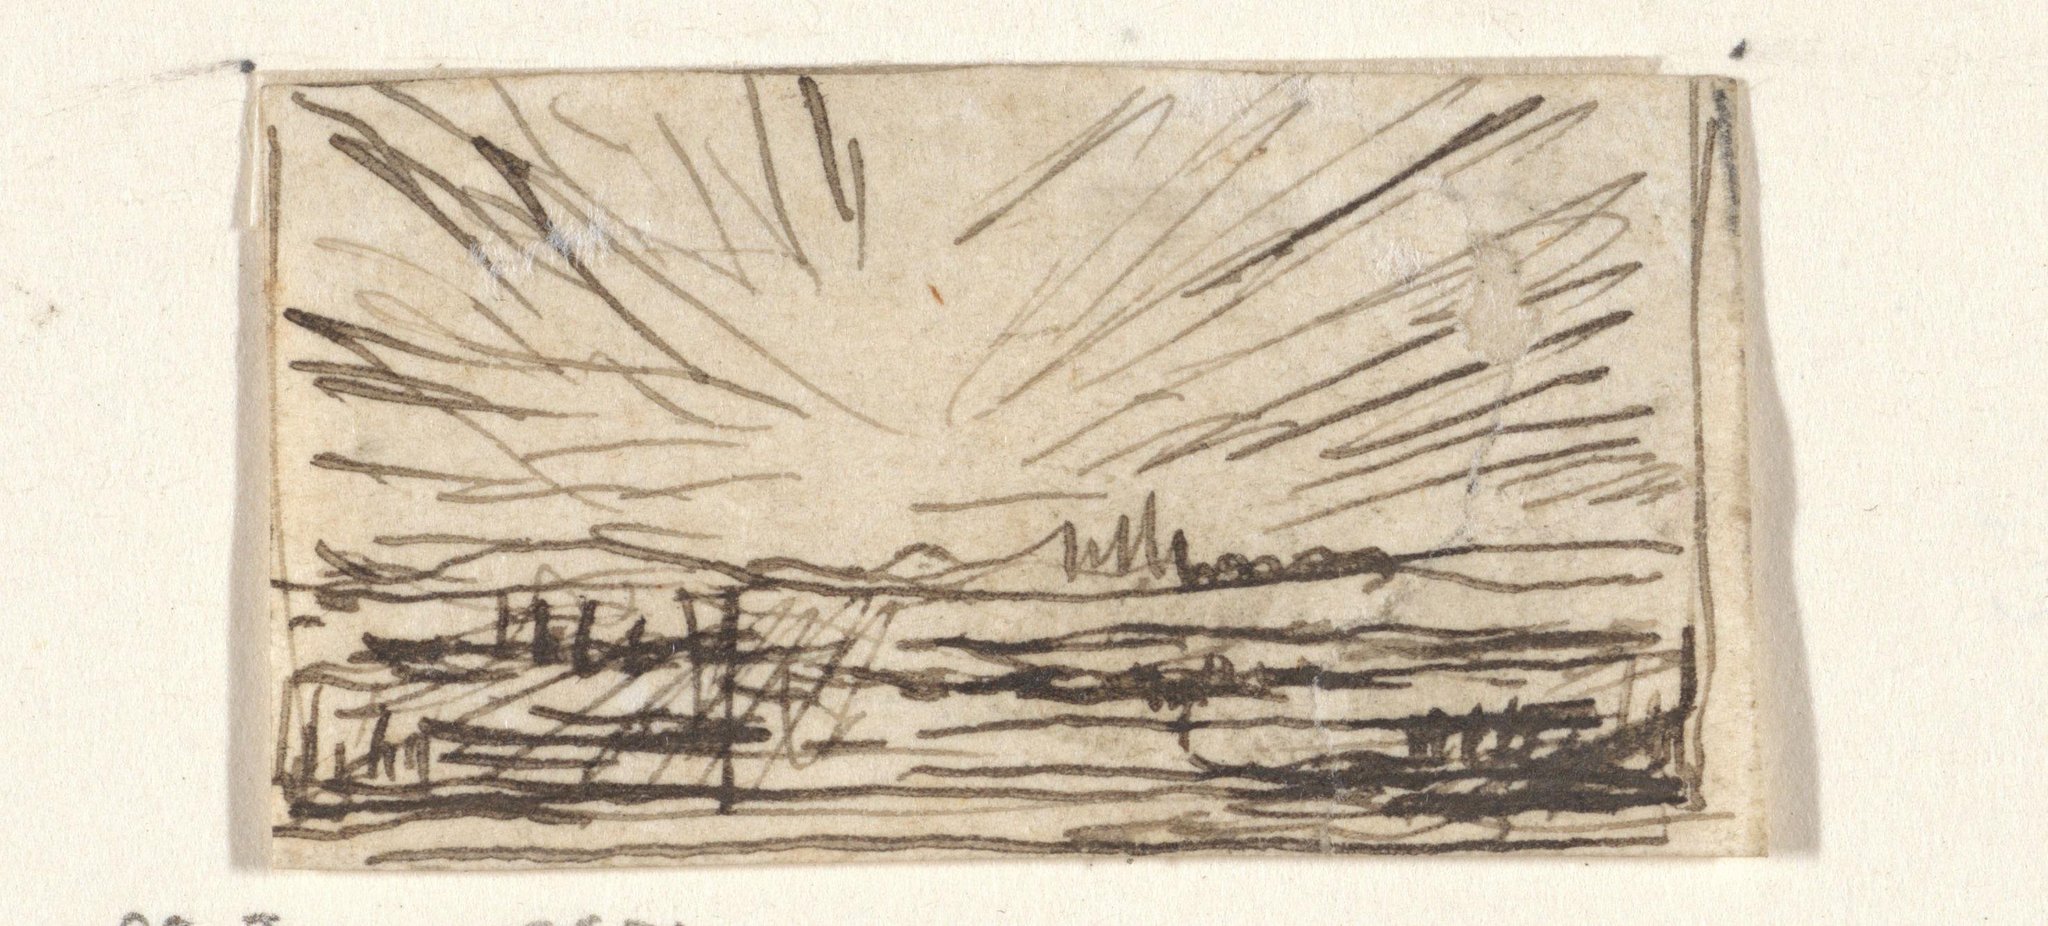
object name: drawing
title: Zonsondergang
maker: thomas cool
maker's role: draughtsman, painter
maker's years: 1851-1904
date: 1861-1904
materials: ink, paper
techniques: pen